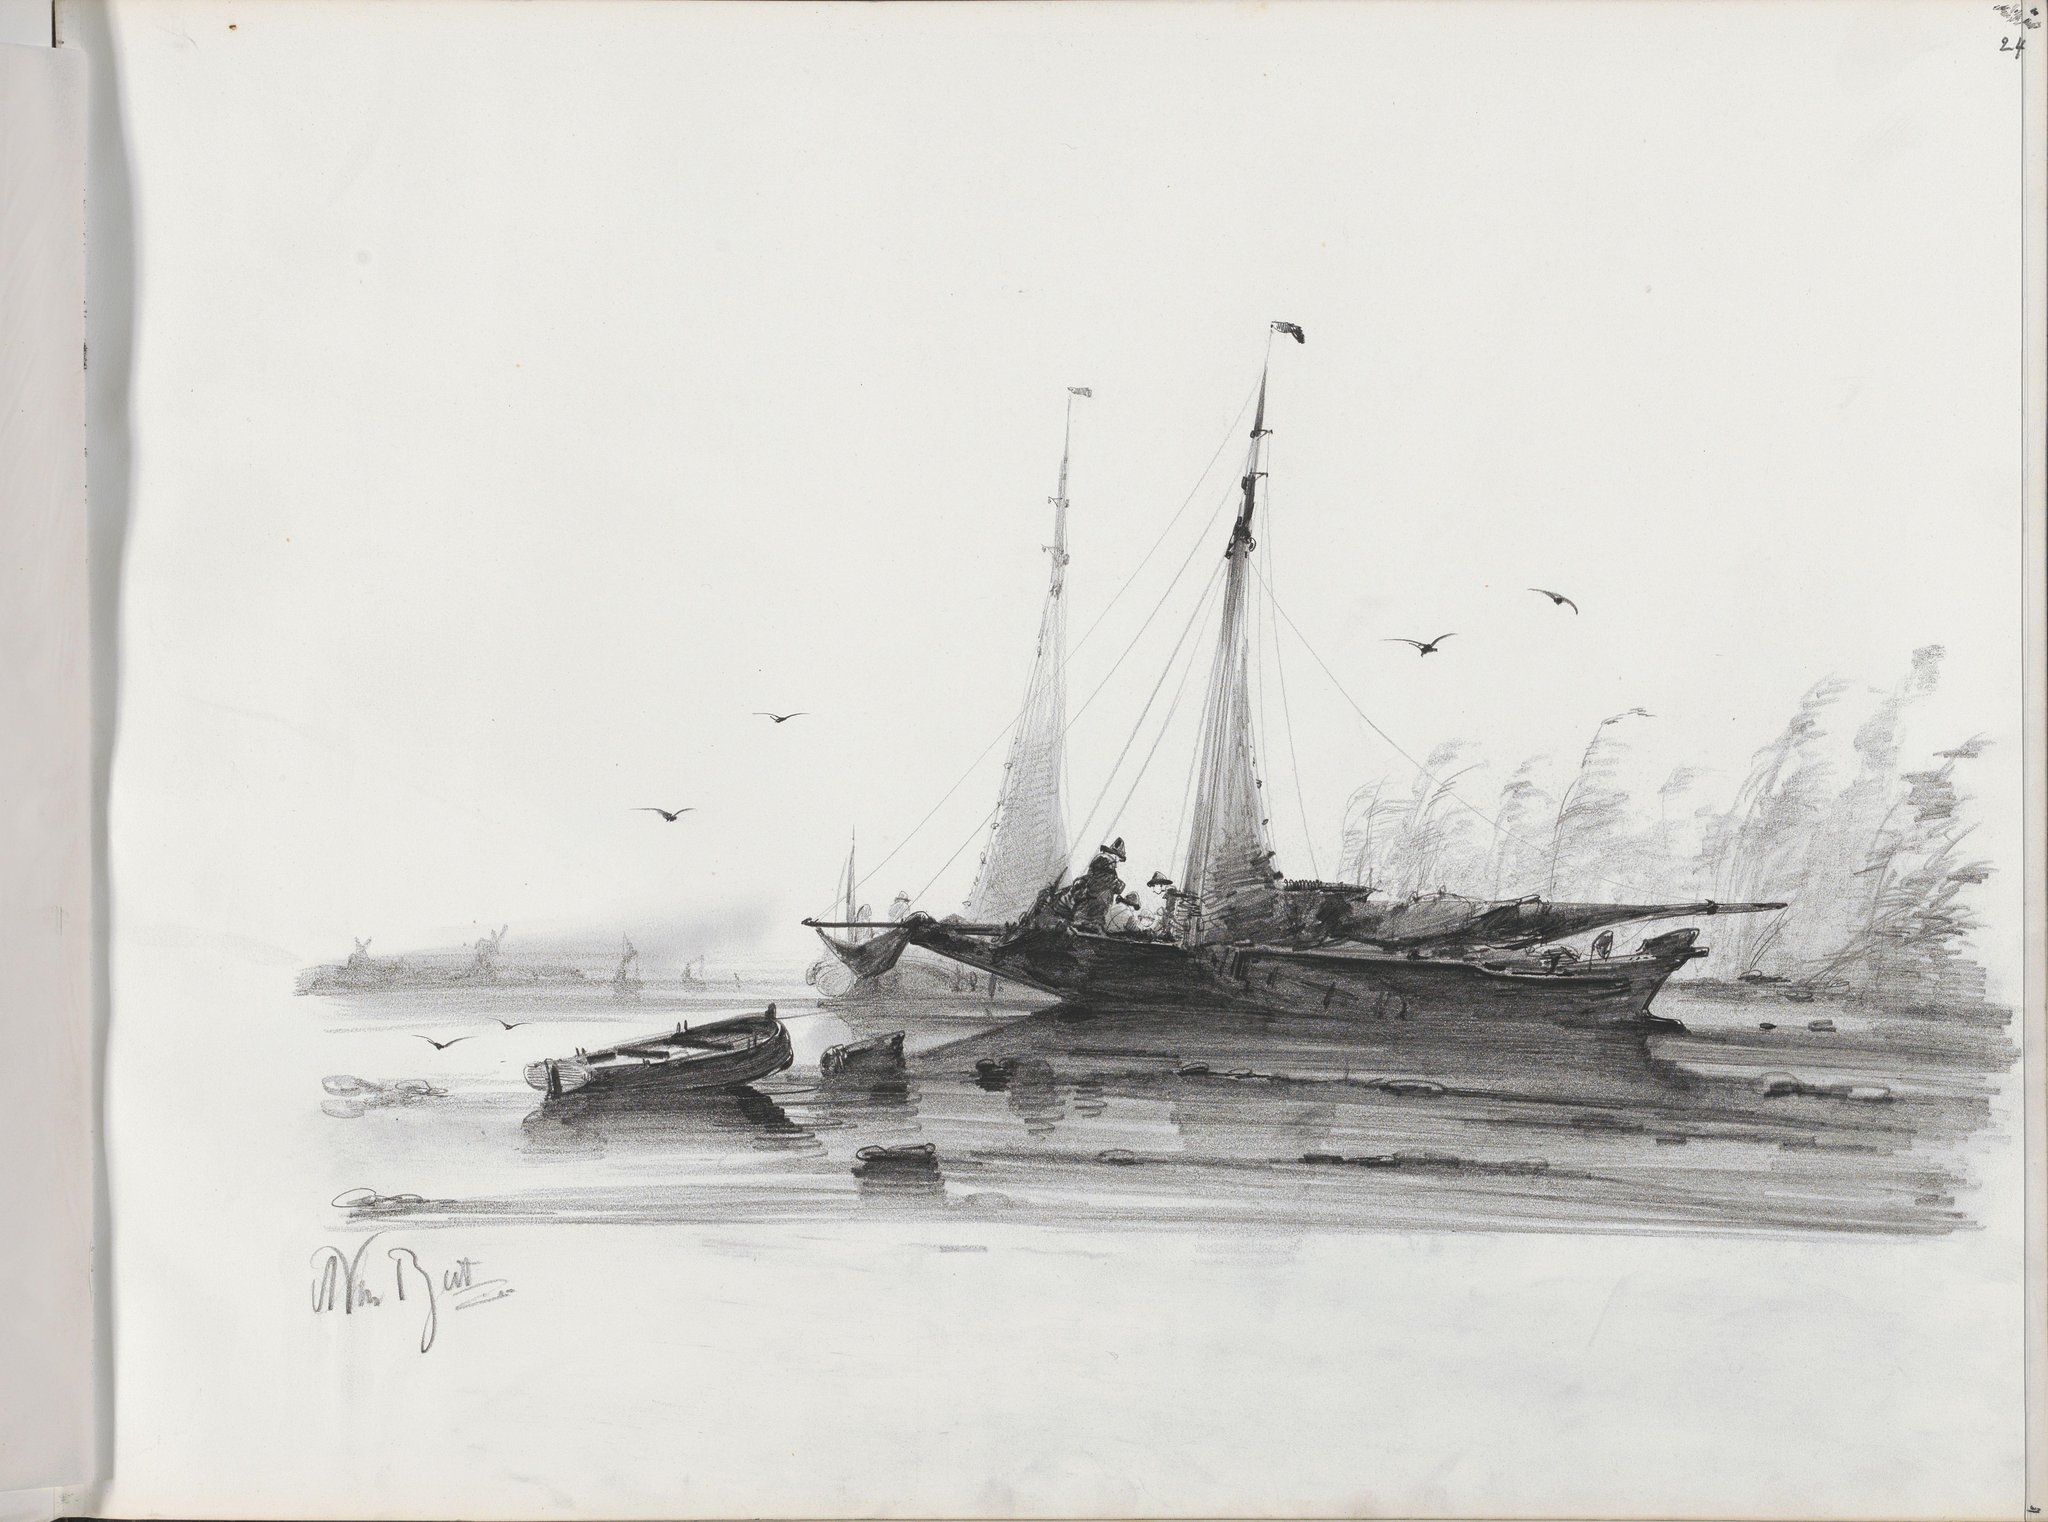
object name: sketchbook leaf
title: Figuren op een afgemeerd zeilschip bij een rietkraag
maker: albertus van beest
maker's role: draughtsman, print maker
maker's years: 1820-1860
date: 1830-1860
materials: paper, pencil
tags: sailing-ship, sailing-boat, windmill in landscape, plants and herbs: reed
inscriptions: signature: ‘AVan Beest.’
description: Op de achtergrond zeilschepen en molens. Blad 24 recto uit een schetsboek met 46 bladen.